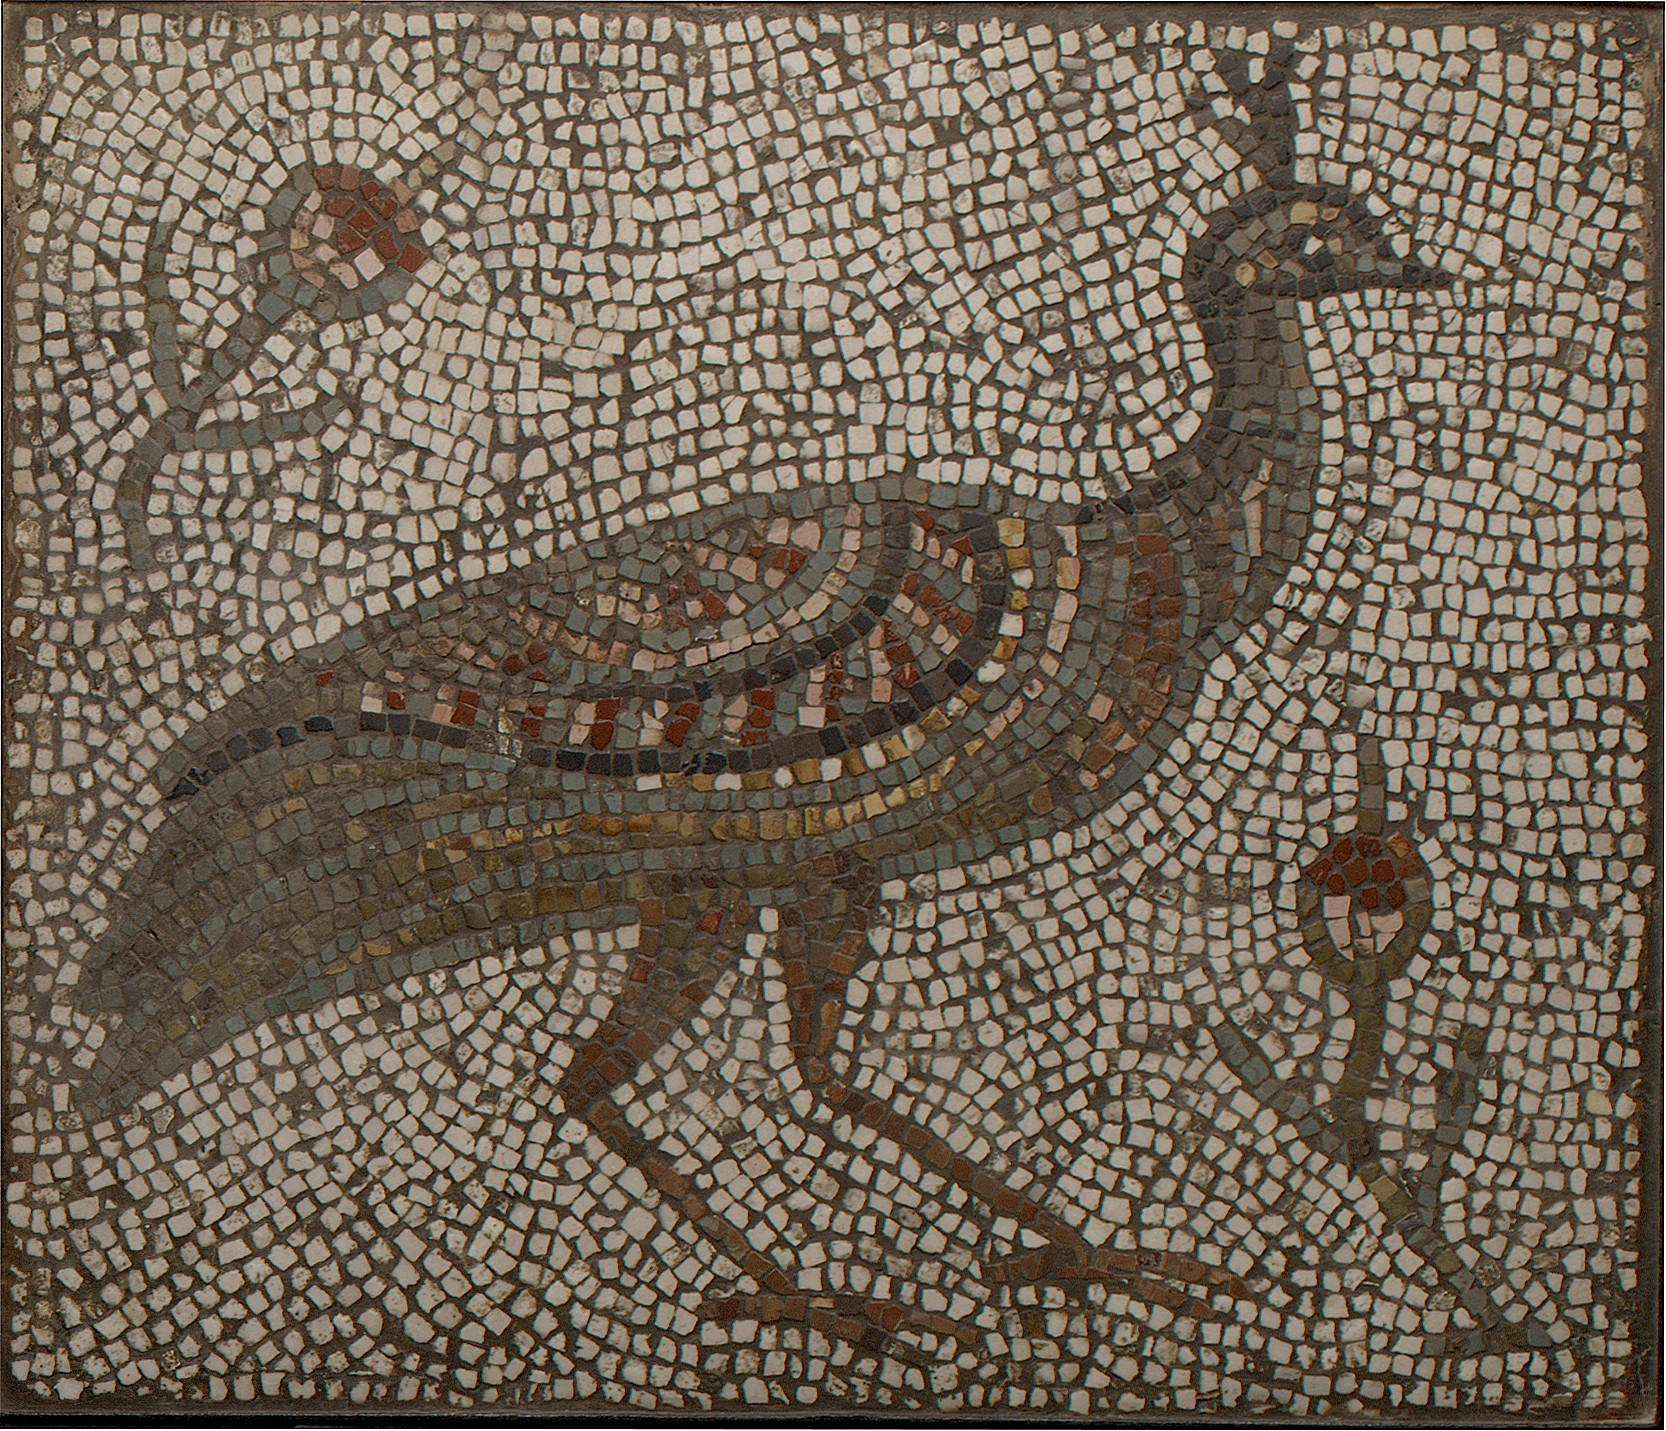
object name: mosaic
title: Mosaic with a Peacock and Flowers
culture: byzantine or roman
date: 201-400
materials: metal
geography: north africa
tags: peacocks